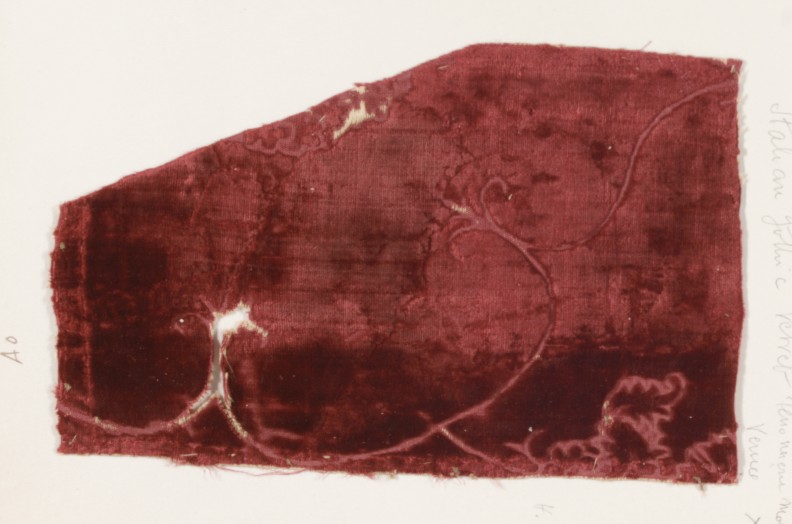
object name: fragment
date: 1401-1500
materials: silk